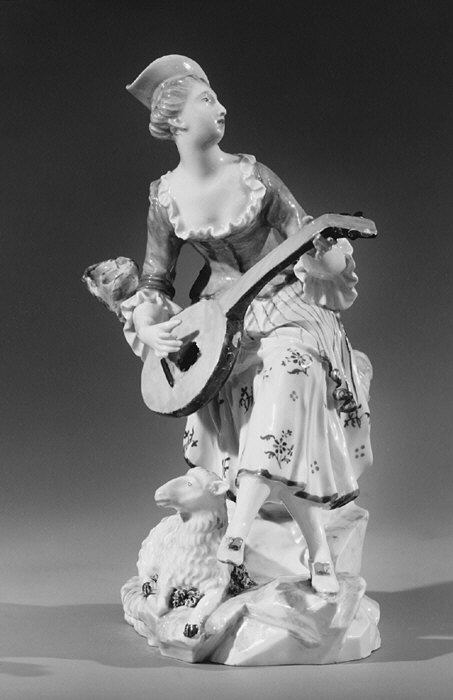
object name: figure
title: Woman playing a mandolin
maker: ludwigsburg porcelain manufactory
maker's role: manufactory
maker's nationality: german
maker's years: 1758-1824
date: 1770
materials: hard paste porcelain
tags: women,mandolins,sheep,musicians